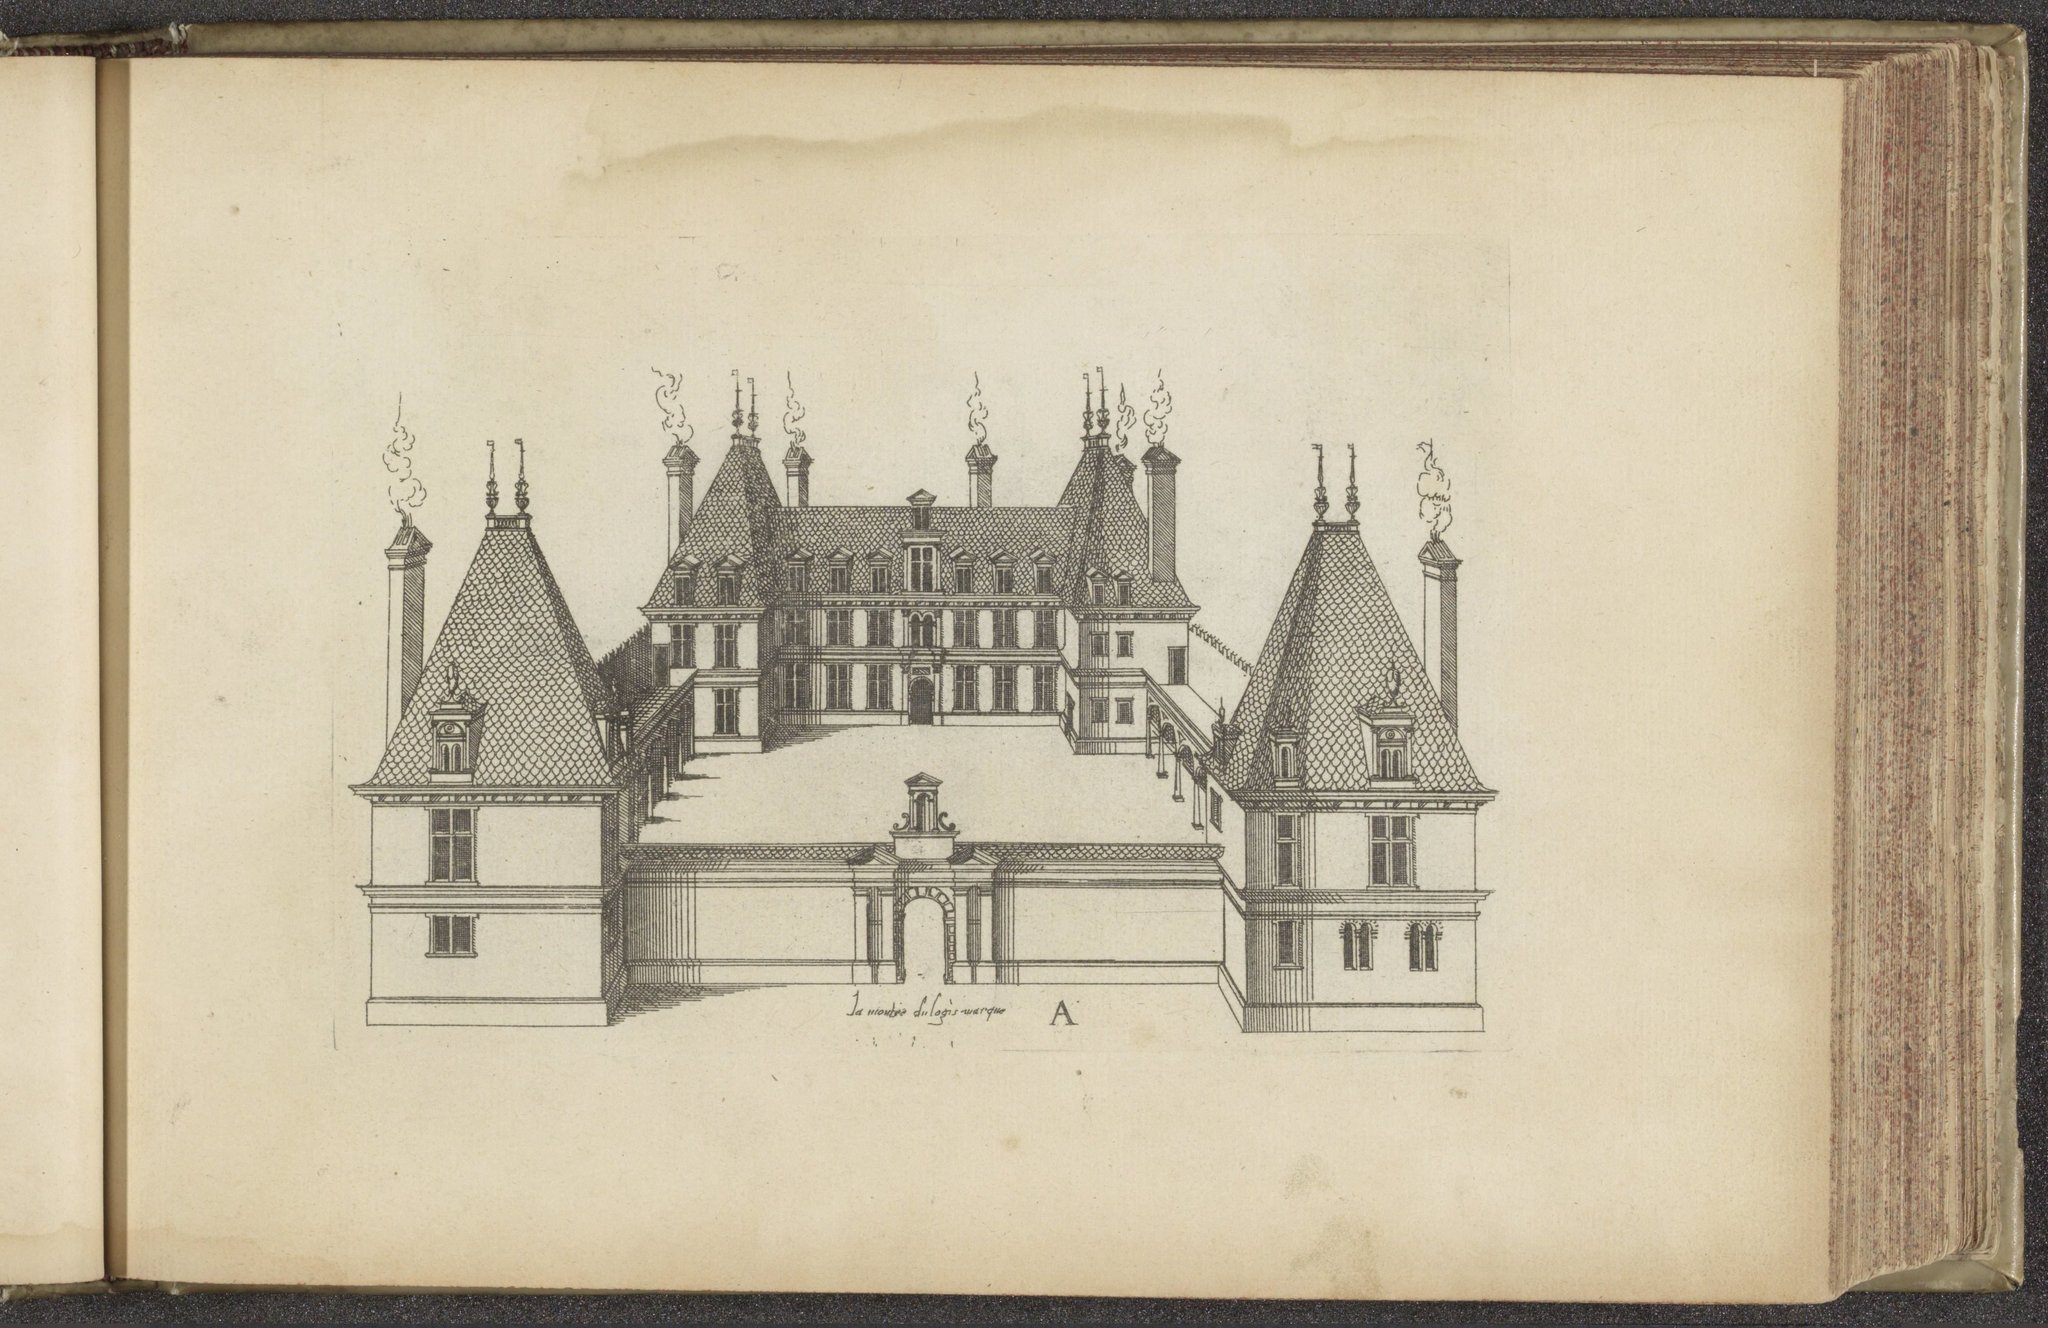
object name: album leaf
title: Logis domestiques / Petit Habitations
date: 1540-1545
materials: paper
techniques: etching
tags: castle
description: Deze prent maakt deel uit van een album.